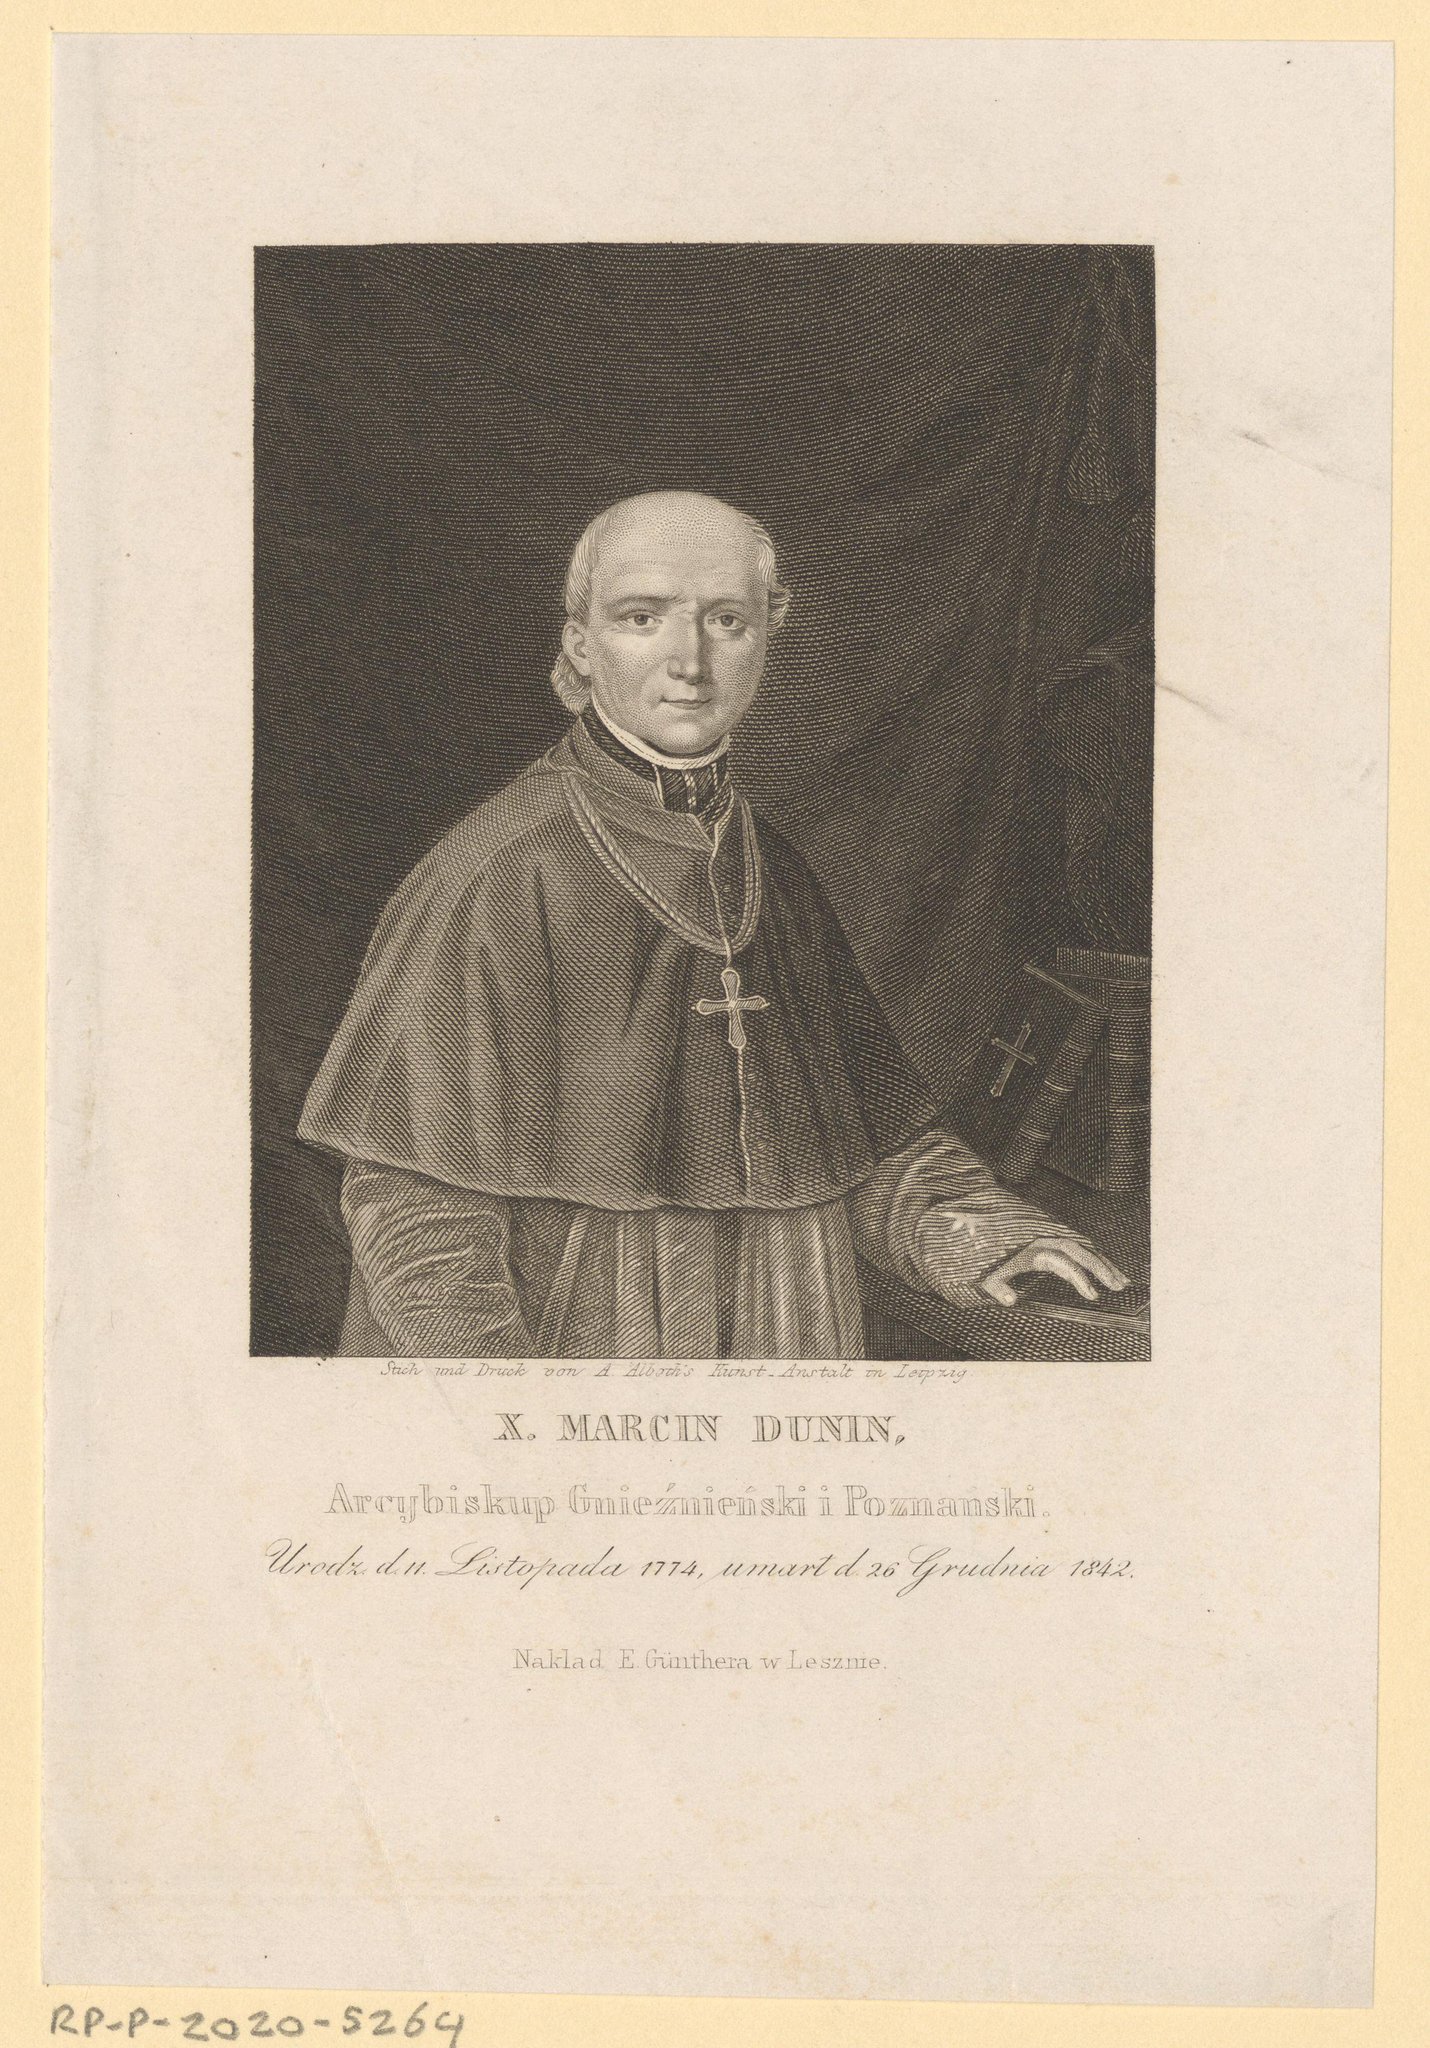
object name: print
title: Portret van Martin von Dunin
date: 1834-1888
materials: paper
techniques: engraving, etching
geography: leipzig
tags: archbishop, bishop, etc. (roman catholic), historical persons